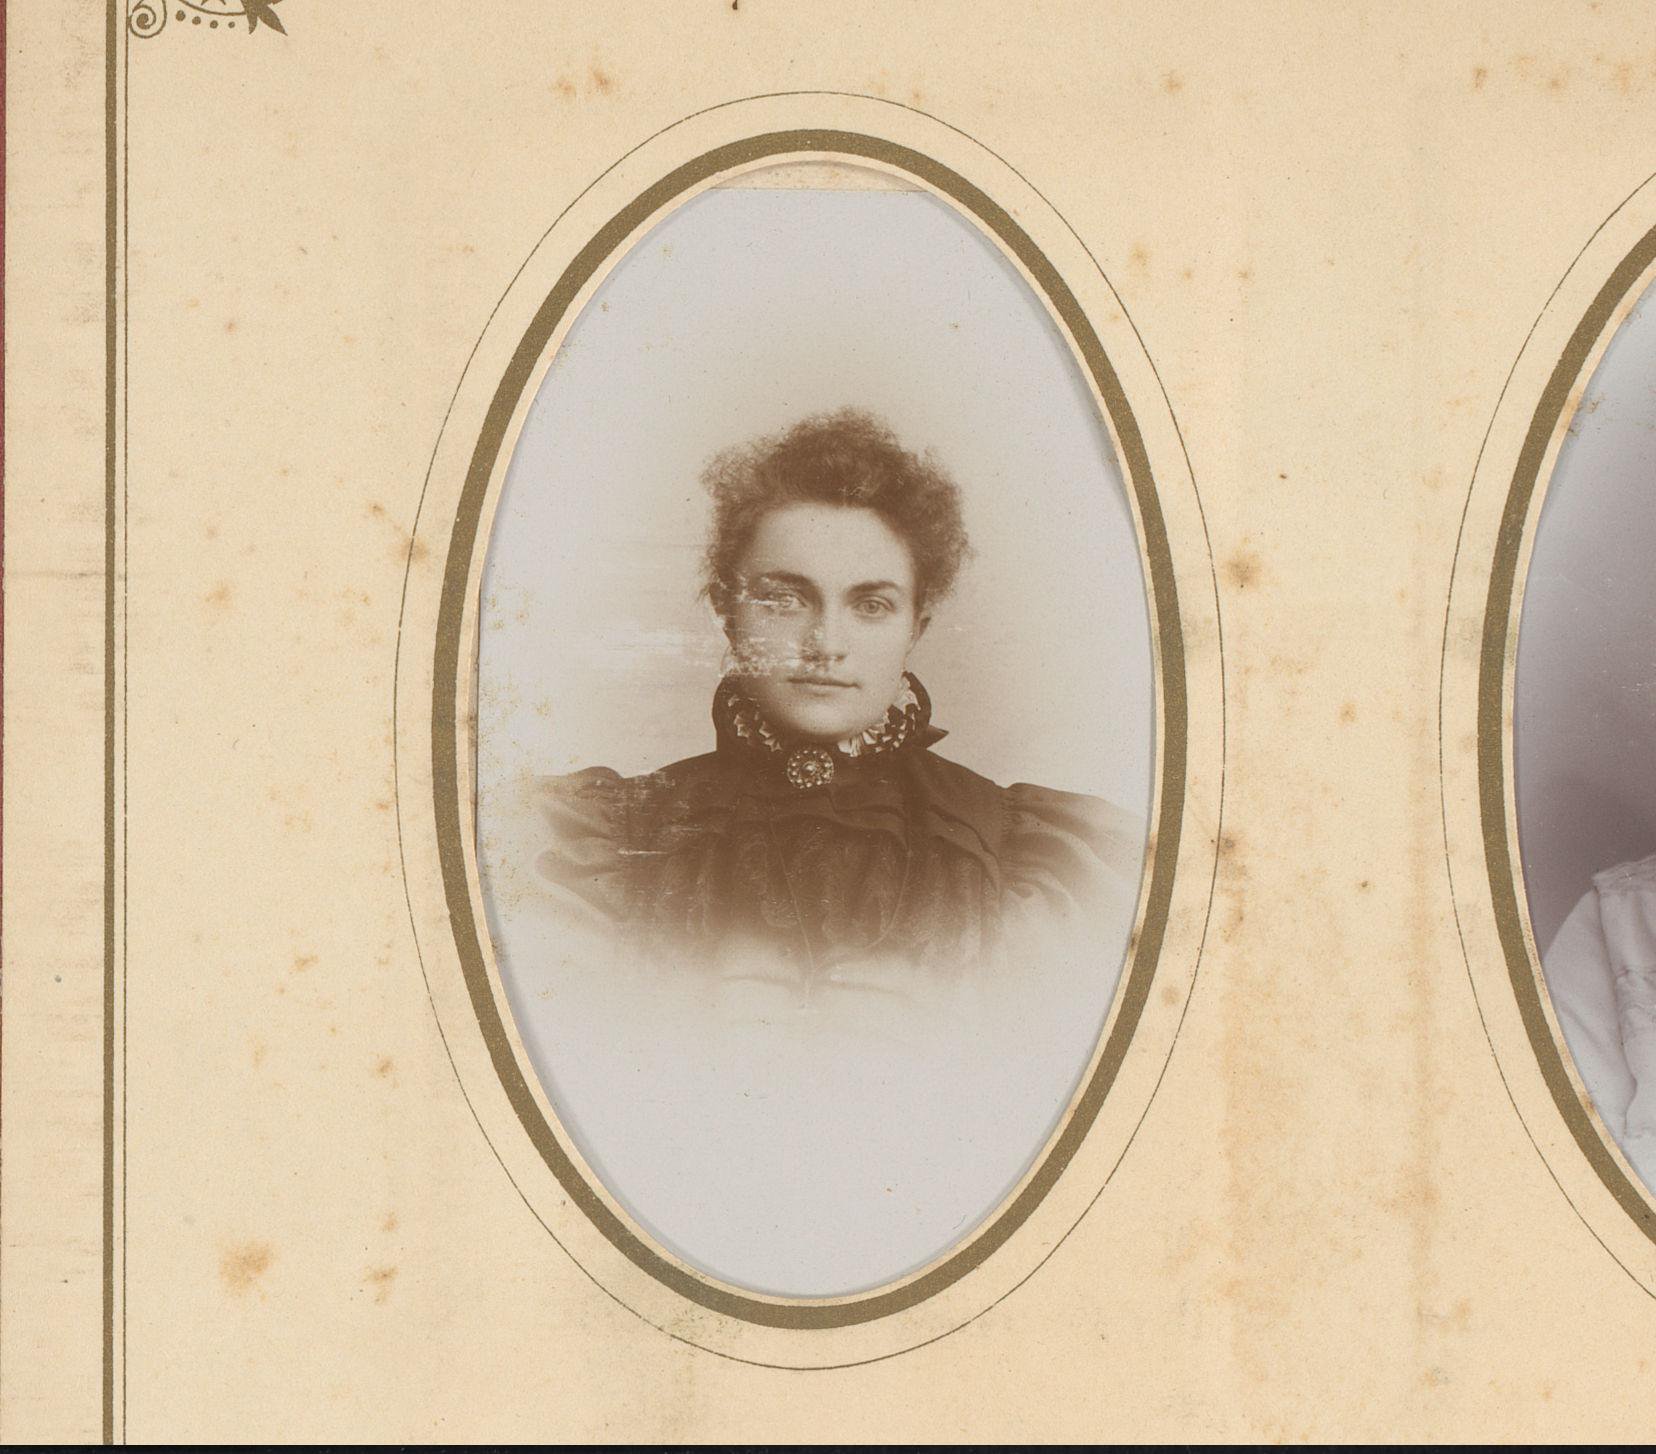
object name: carte de visite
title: Portret van een vrouw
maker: aaltje de jong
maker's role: fotograaf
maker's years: 1864-1936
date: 1895-1917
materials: cardboard, photographic support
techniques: collodion silver print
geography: leeuwarden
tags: historical persons - bb - woman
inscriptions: inscription: ‘Photographie/ de Jong/ Nieuwe Stad 53/ Smalle zijde./ Leeuwarden./ De plaat blijft ter nabestelling bewaard.’